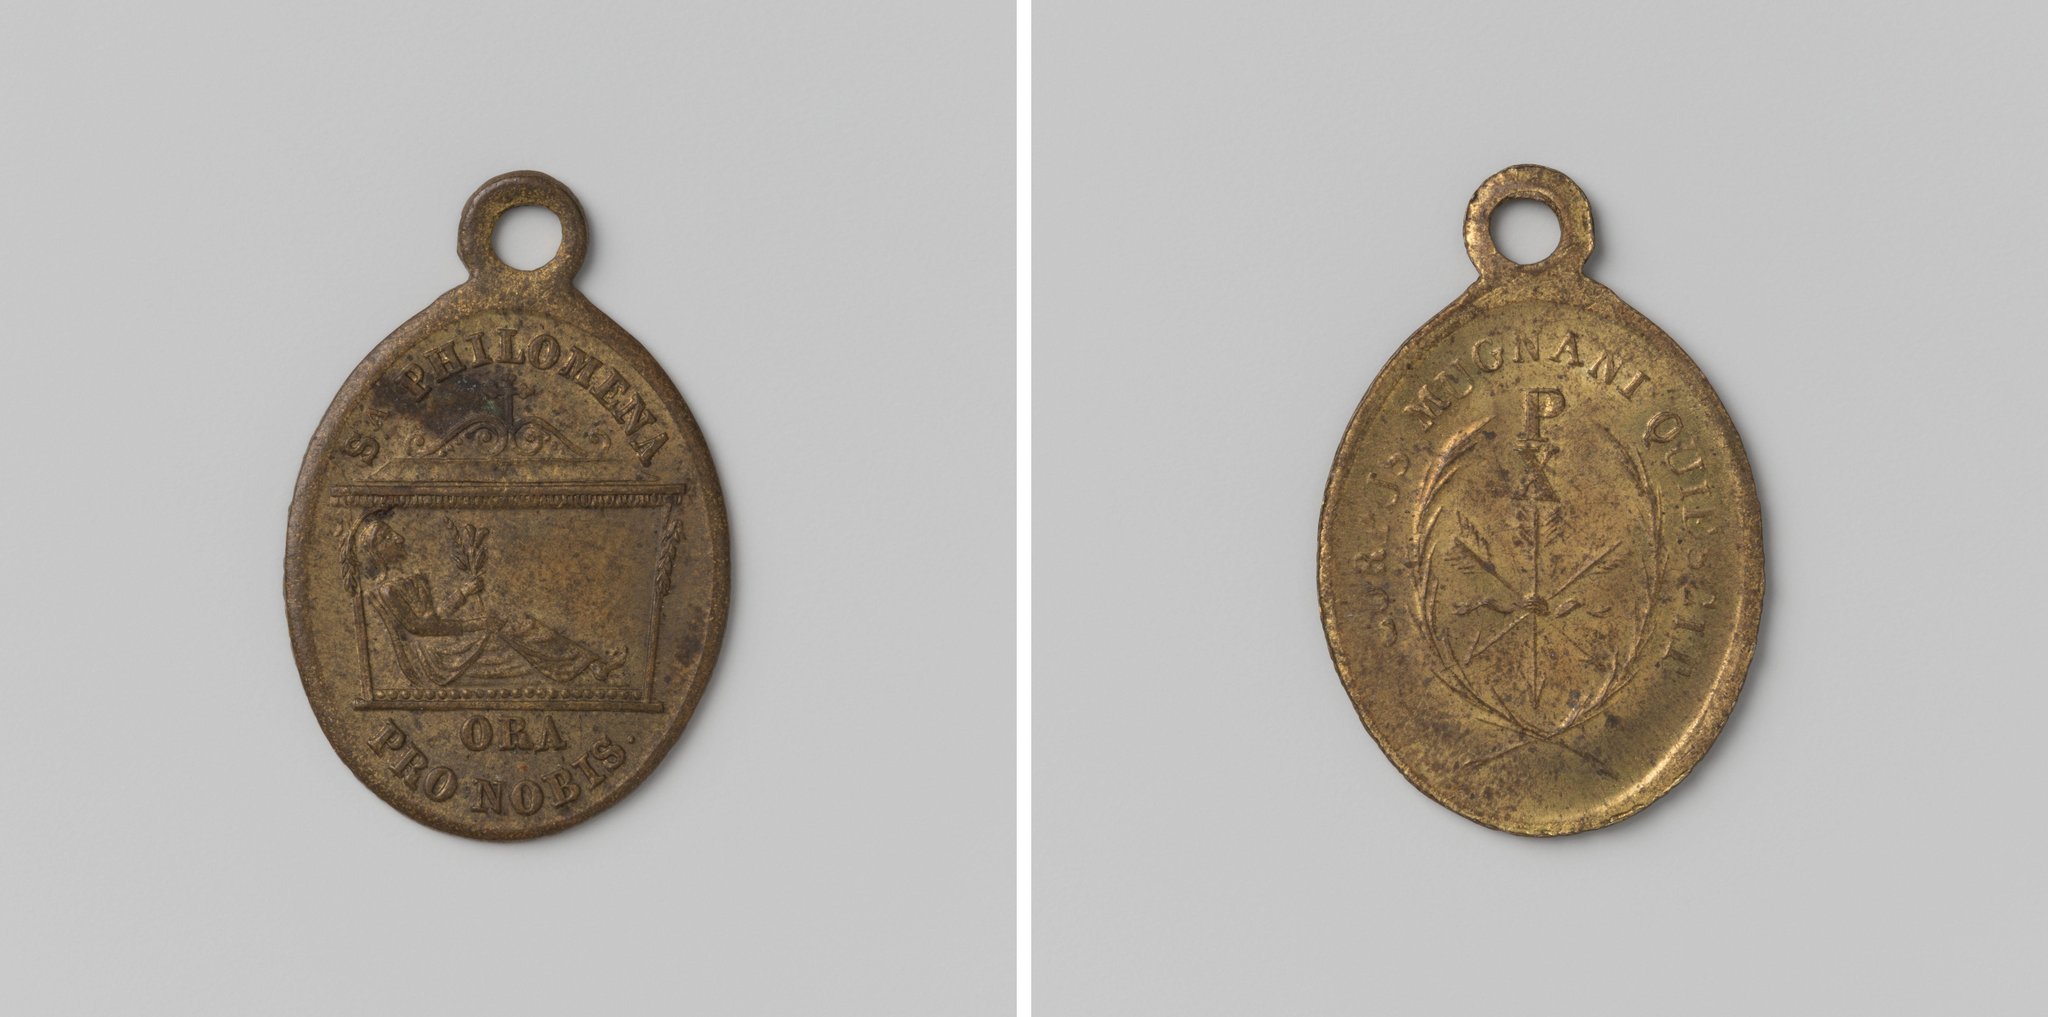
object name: devotional medal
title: Heilige Philomena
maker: Anonymous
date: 1800-1850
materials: brass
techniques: striking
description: Messing ovale penning aan draagoog. Voorzijde: vrouw met tak in hand, zittend in doodskist binnen omschrift. Keerzijde: XP-monogram boven drie gekruiste pijlen binnen krans van palmtakken en omschrift